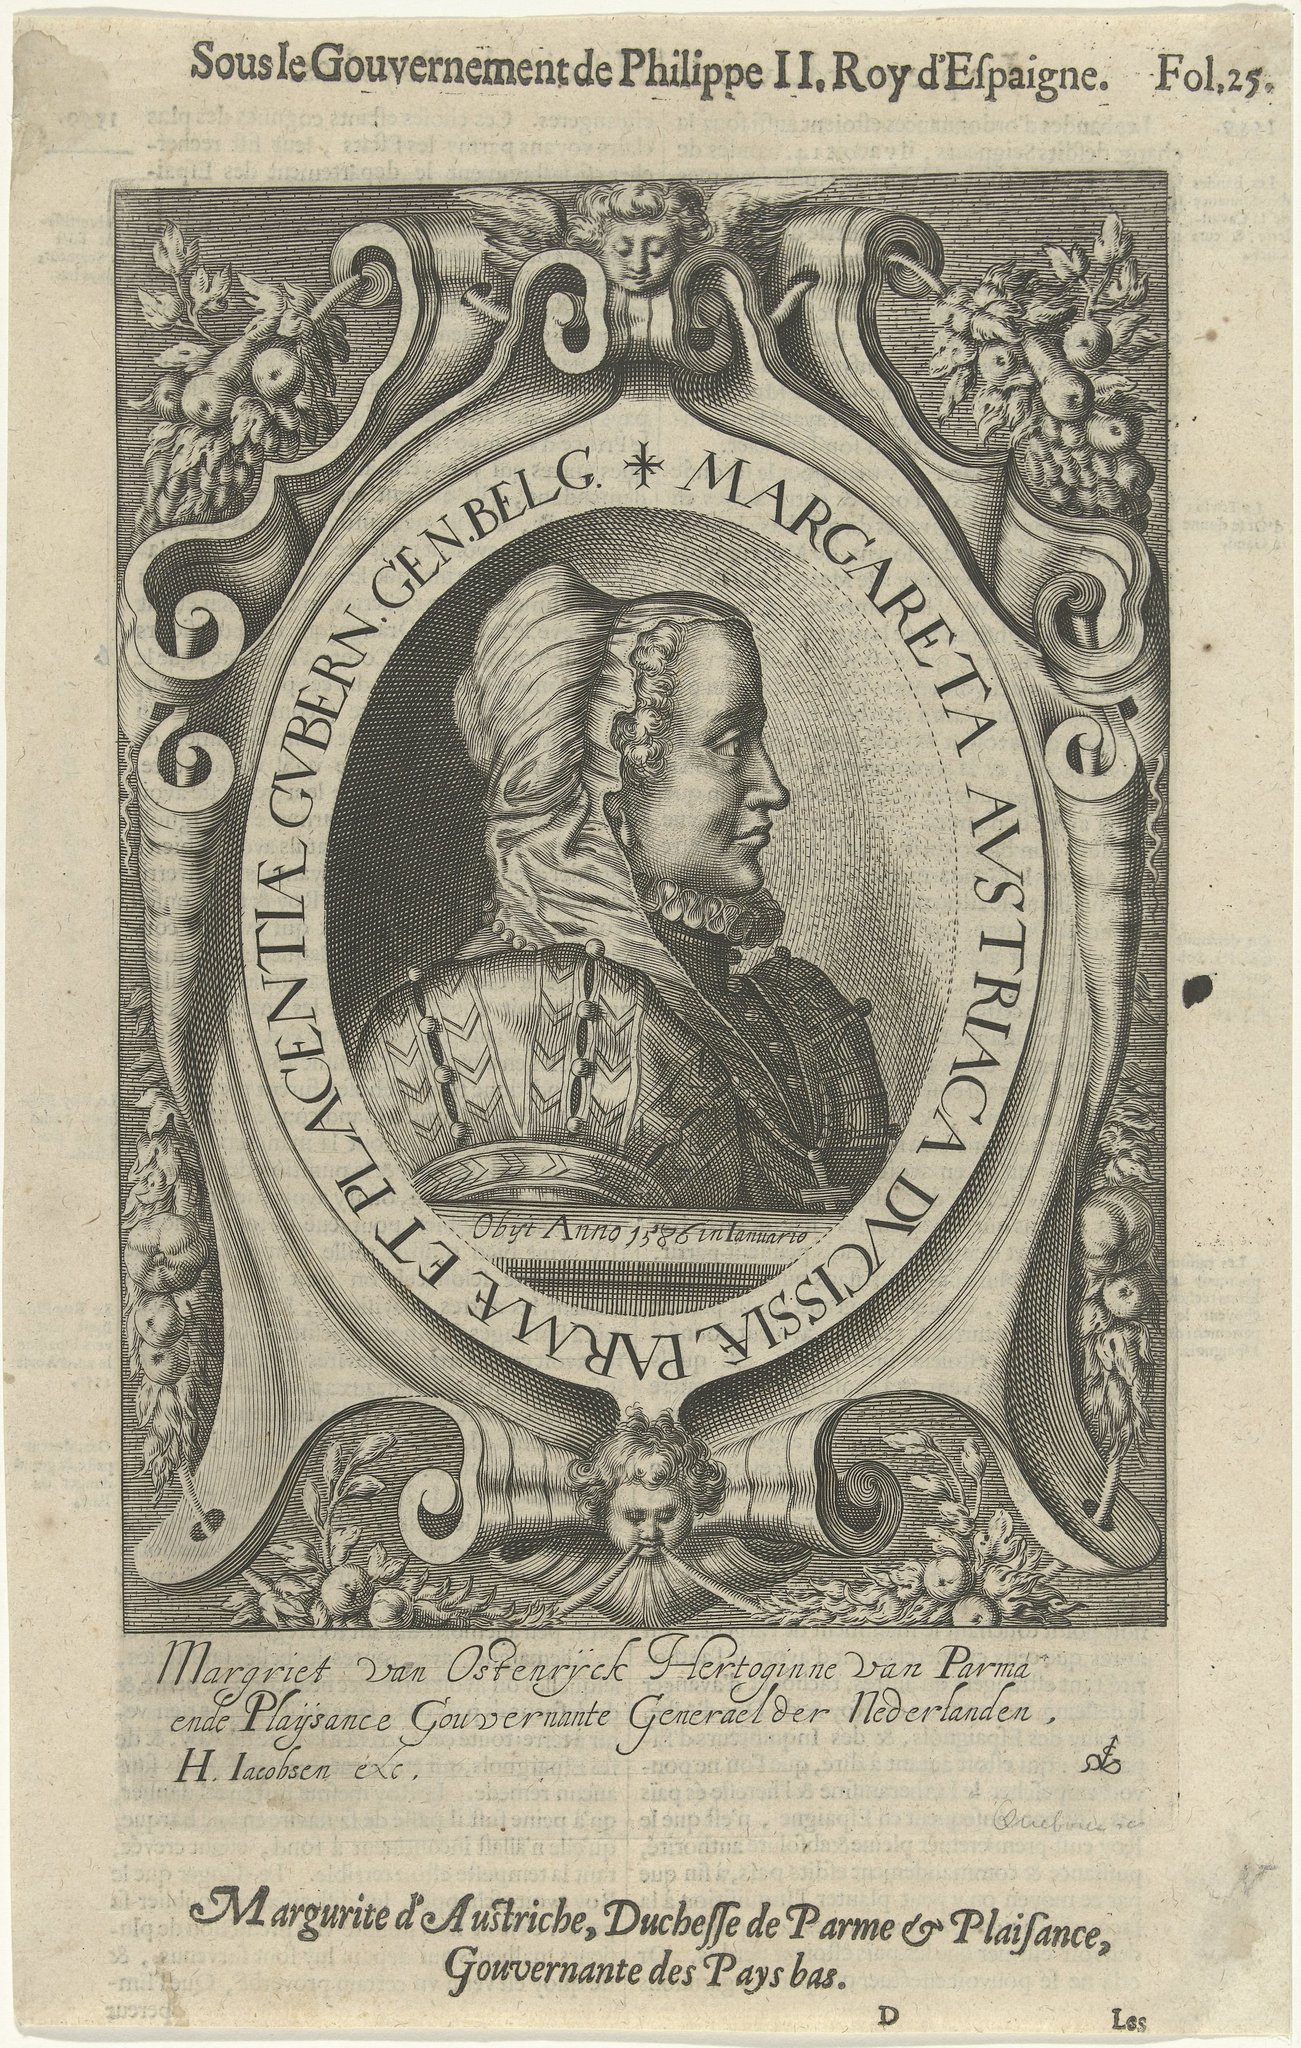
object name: book illustration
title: Portret van Margaretha van Parma, landvoogdes der Nederlanden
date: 1614-1623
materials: paper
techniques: engraving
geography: the hague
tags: ornament ~ festoon, garland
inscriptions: collector's mark: Lugt 2228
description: Portret van Margaretha van Parma, landvoogdes der Nederlanden. Ze is gevat in een rijk gedecoreerde lijst met engeltjes en vruchten. In de marge haar naam en titels.